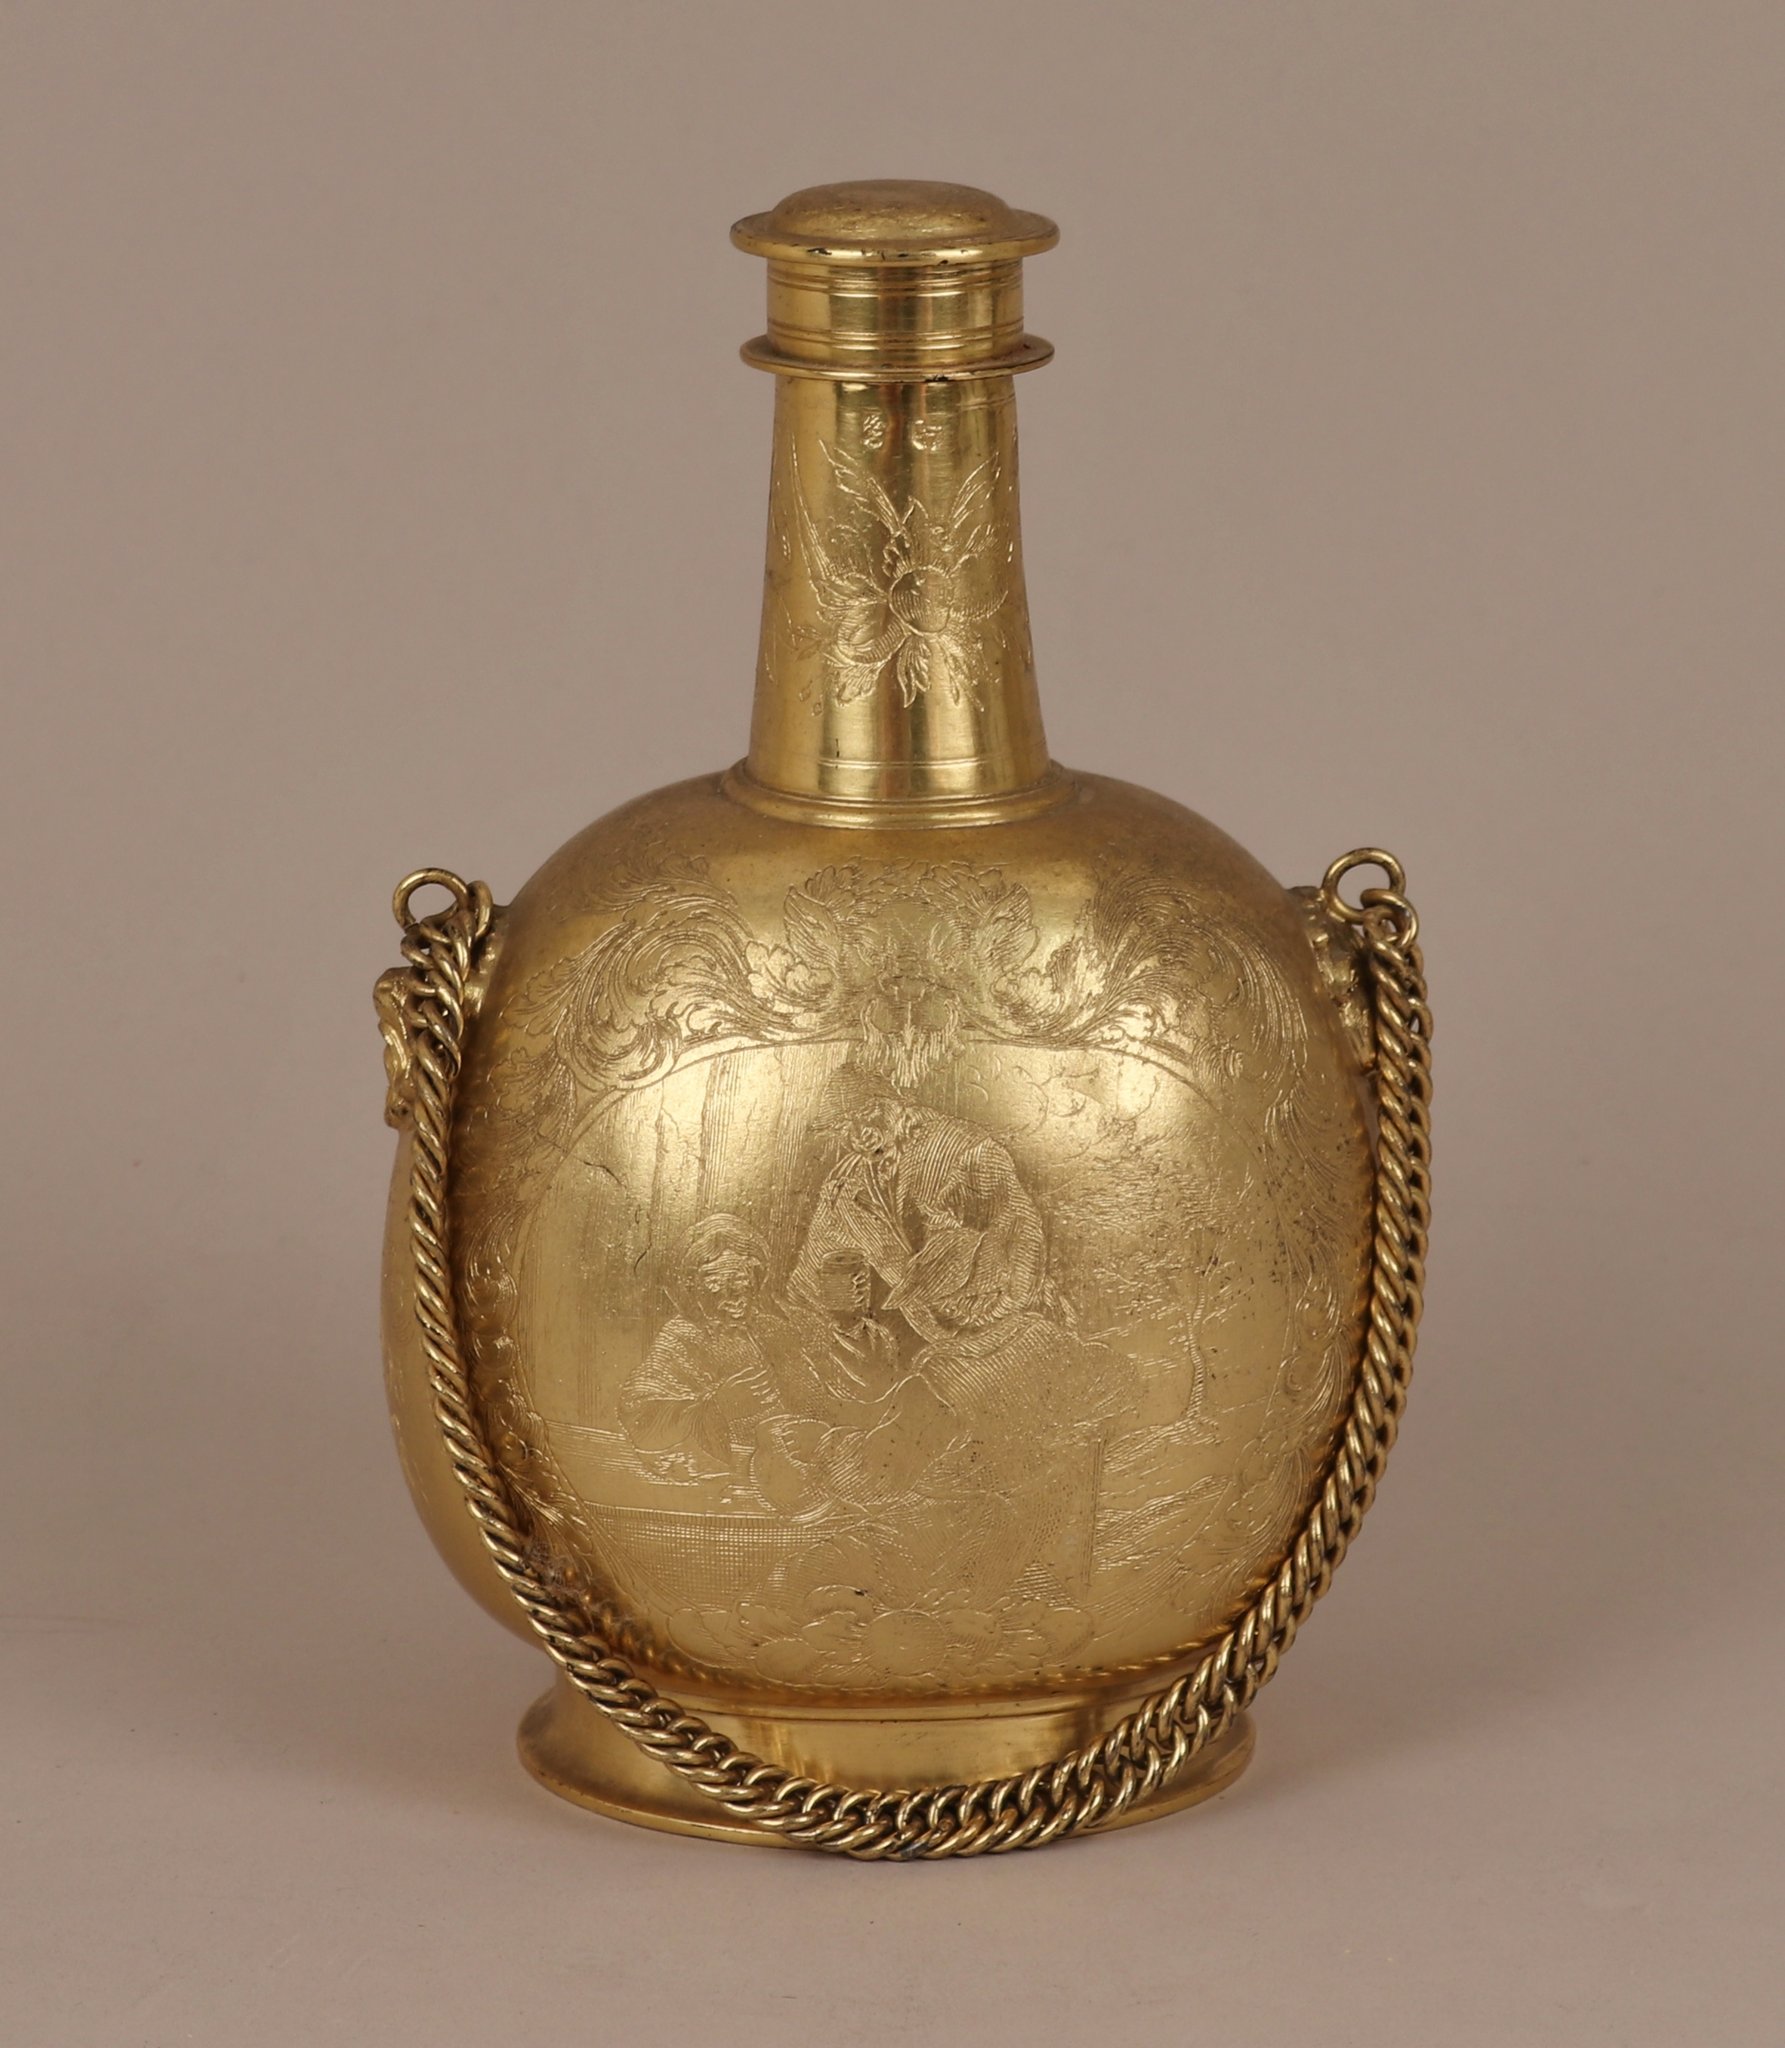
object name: flask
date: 1801-1900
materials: metal, silver